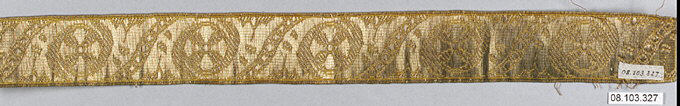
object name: galloon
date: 1801-1900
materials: metal thread, silk